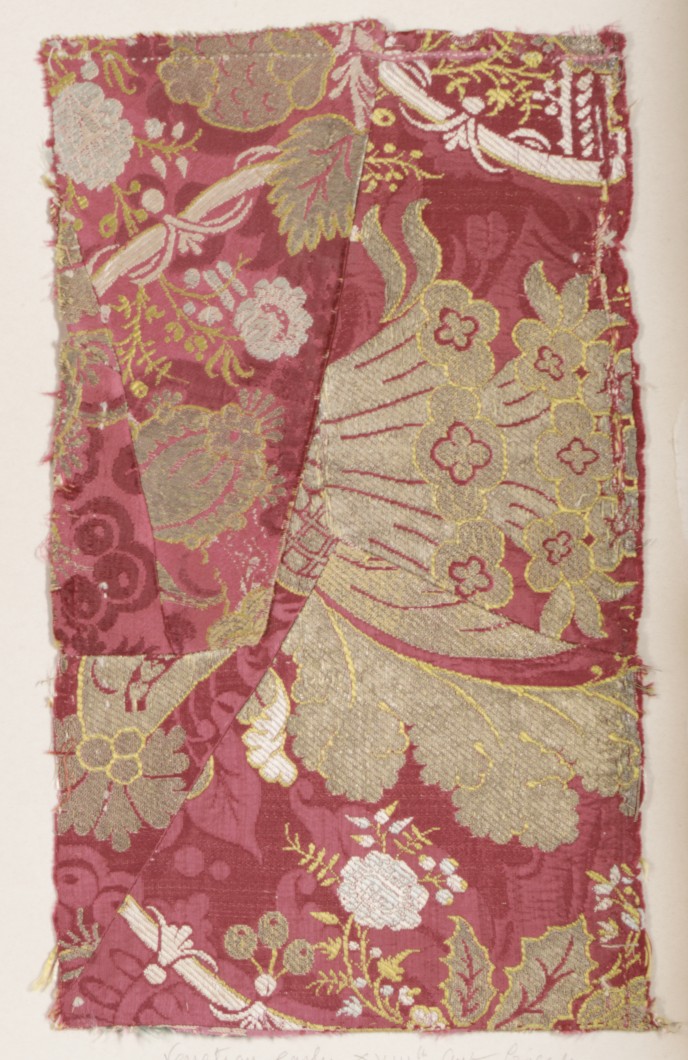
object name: fragment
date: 1701-1800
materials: metal thread, silk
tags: flowers,leaves